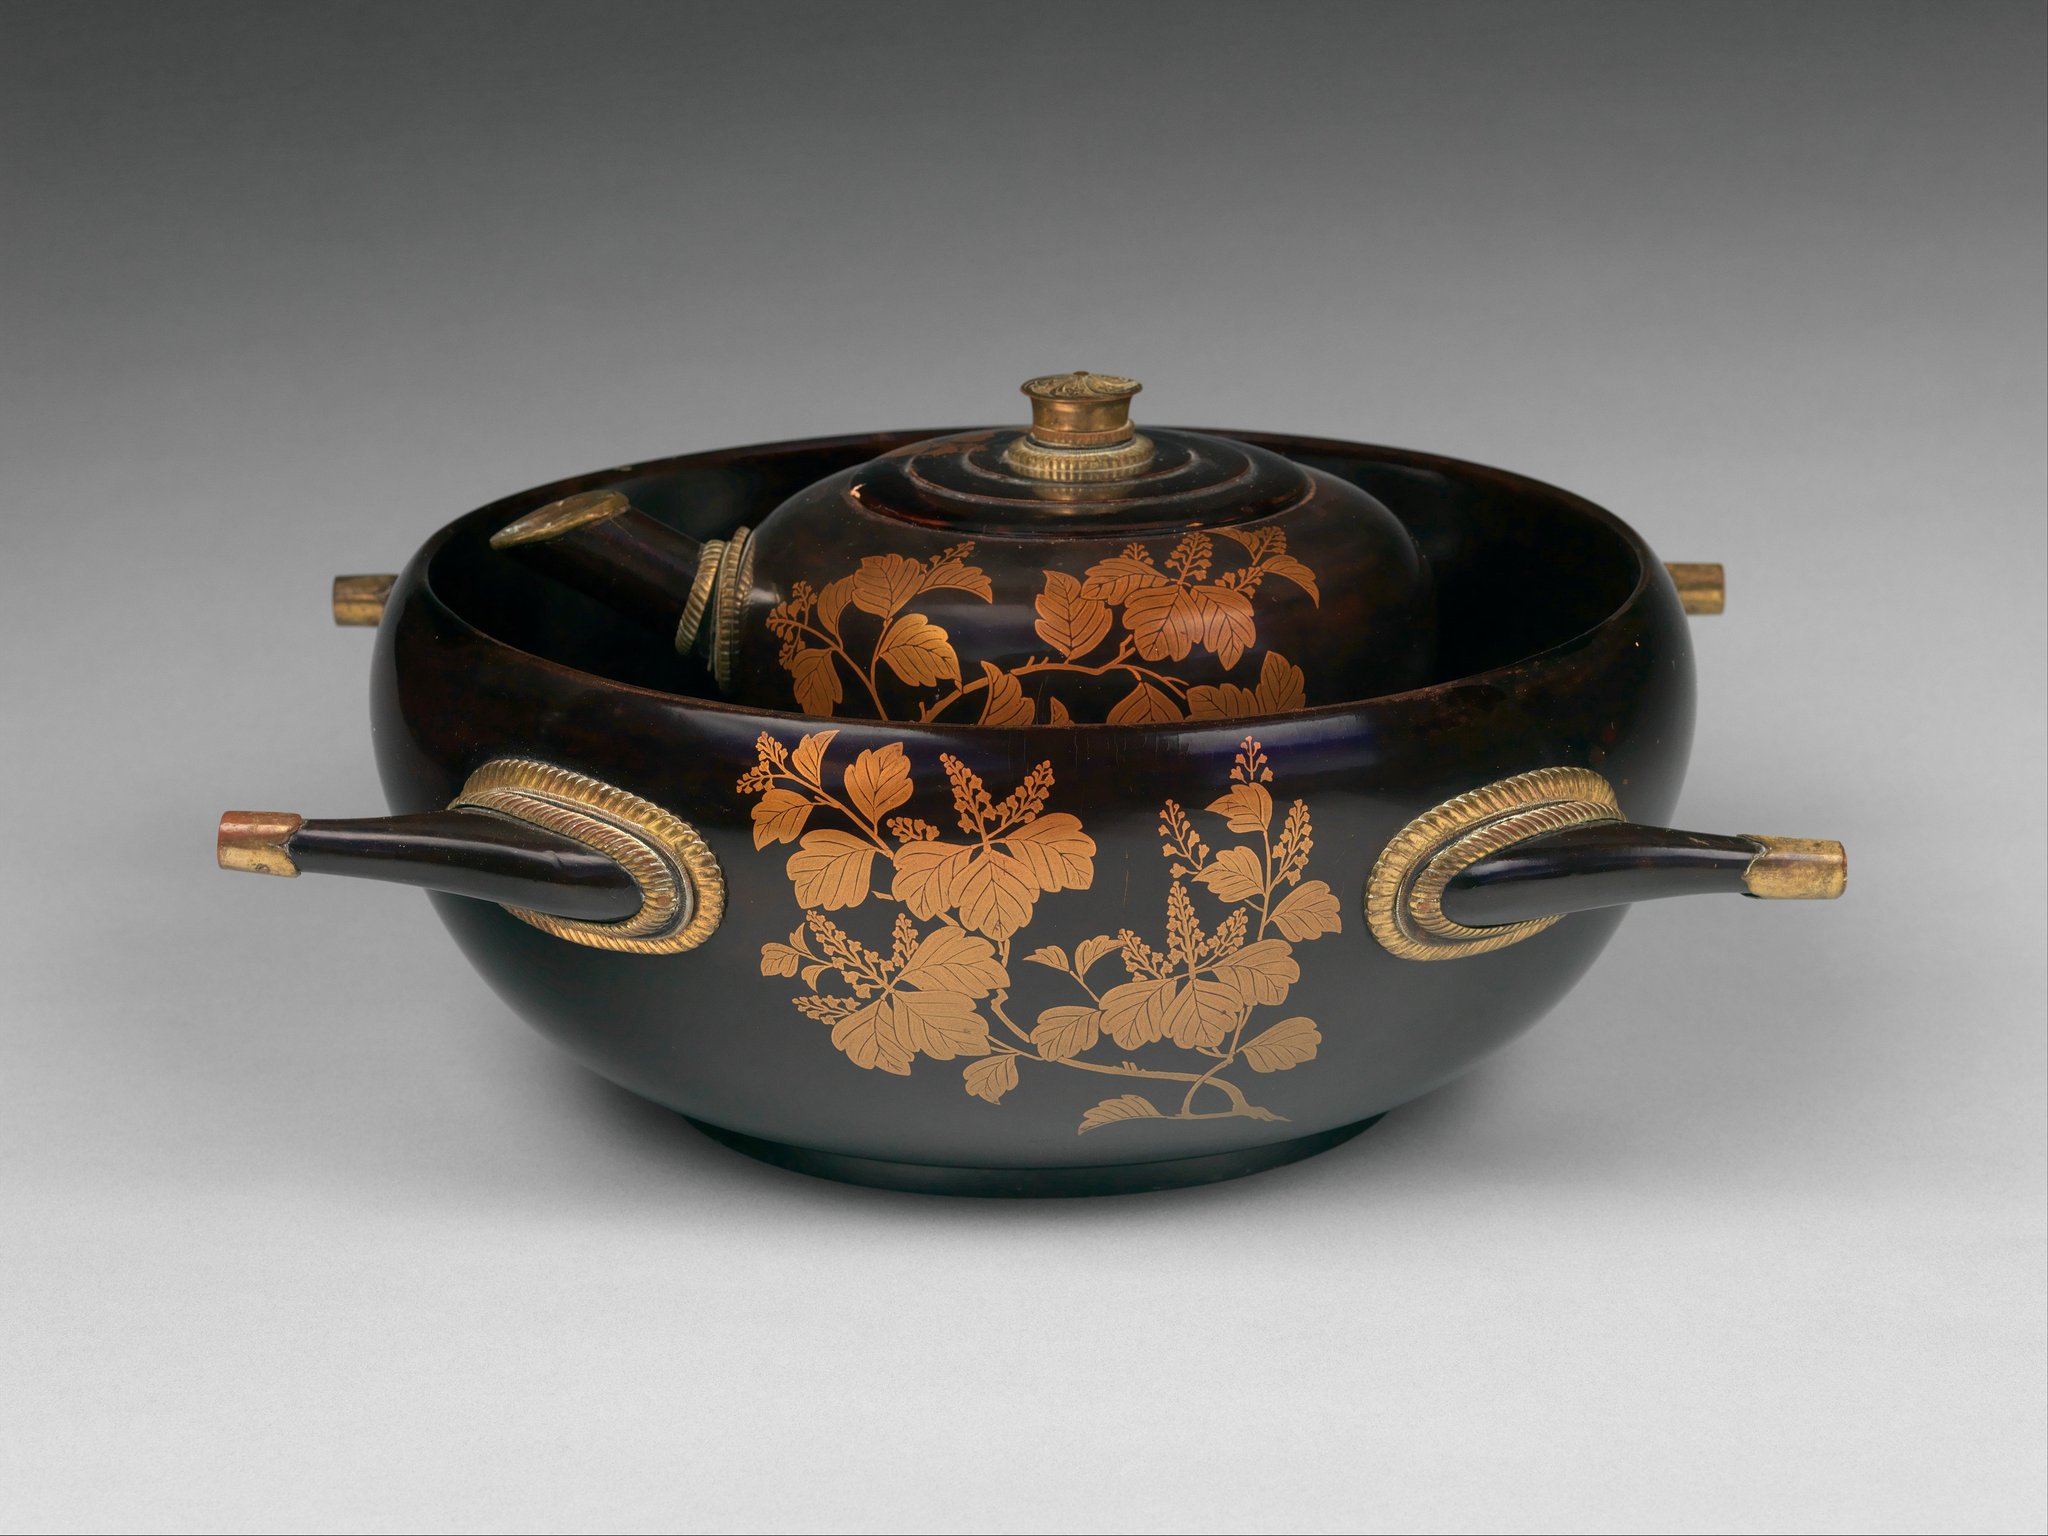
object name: basin and pitcher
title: Four-Handled Basin (Tsunodarai) and Pitcher (Hanzō) with Paulownia and Foliage Scroll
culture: japanese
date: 1601-1700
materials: gilt bronze, gold, wood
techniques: hiramakie, lacquer